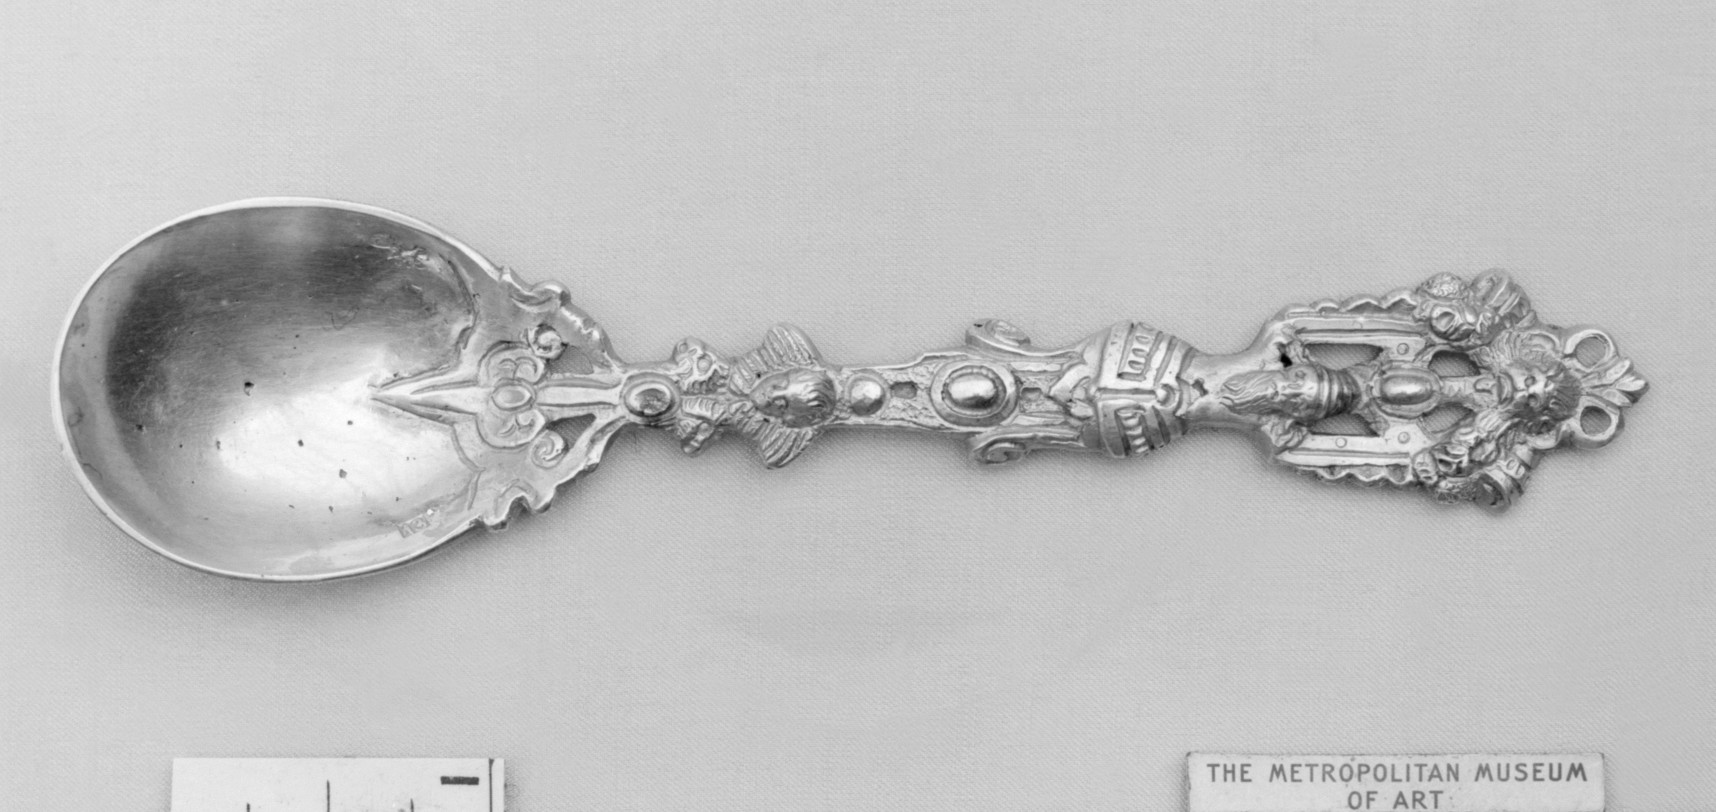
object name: spoon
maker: hans reinhold mühl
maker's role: maker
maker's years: 1654-1692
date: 1667-1700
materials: silver gilt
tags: men